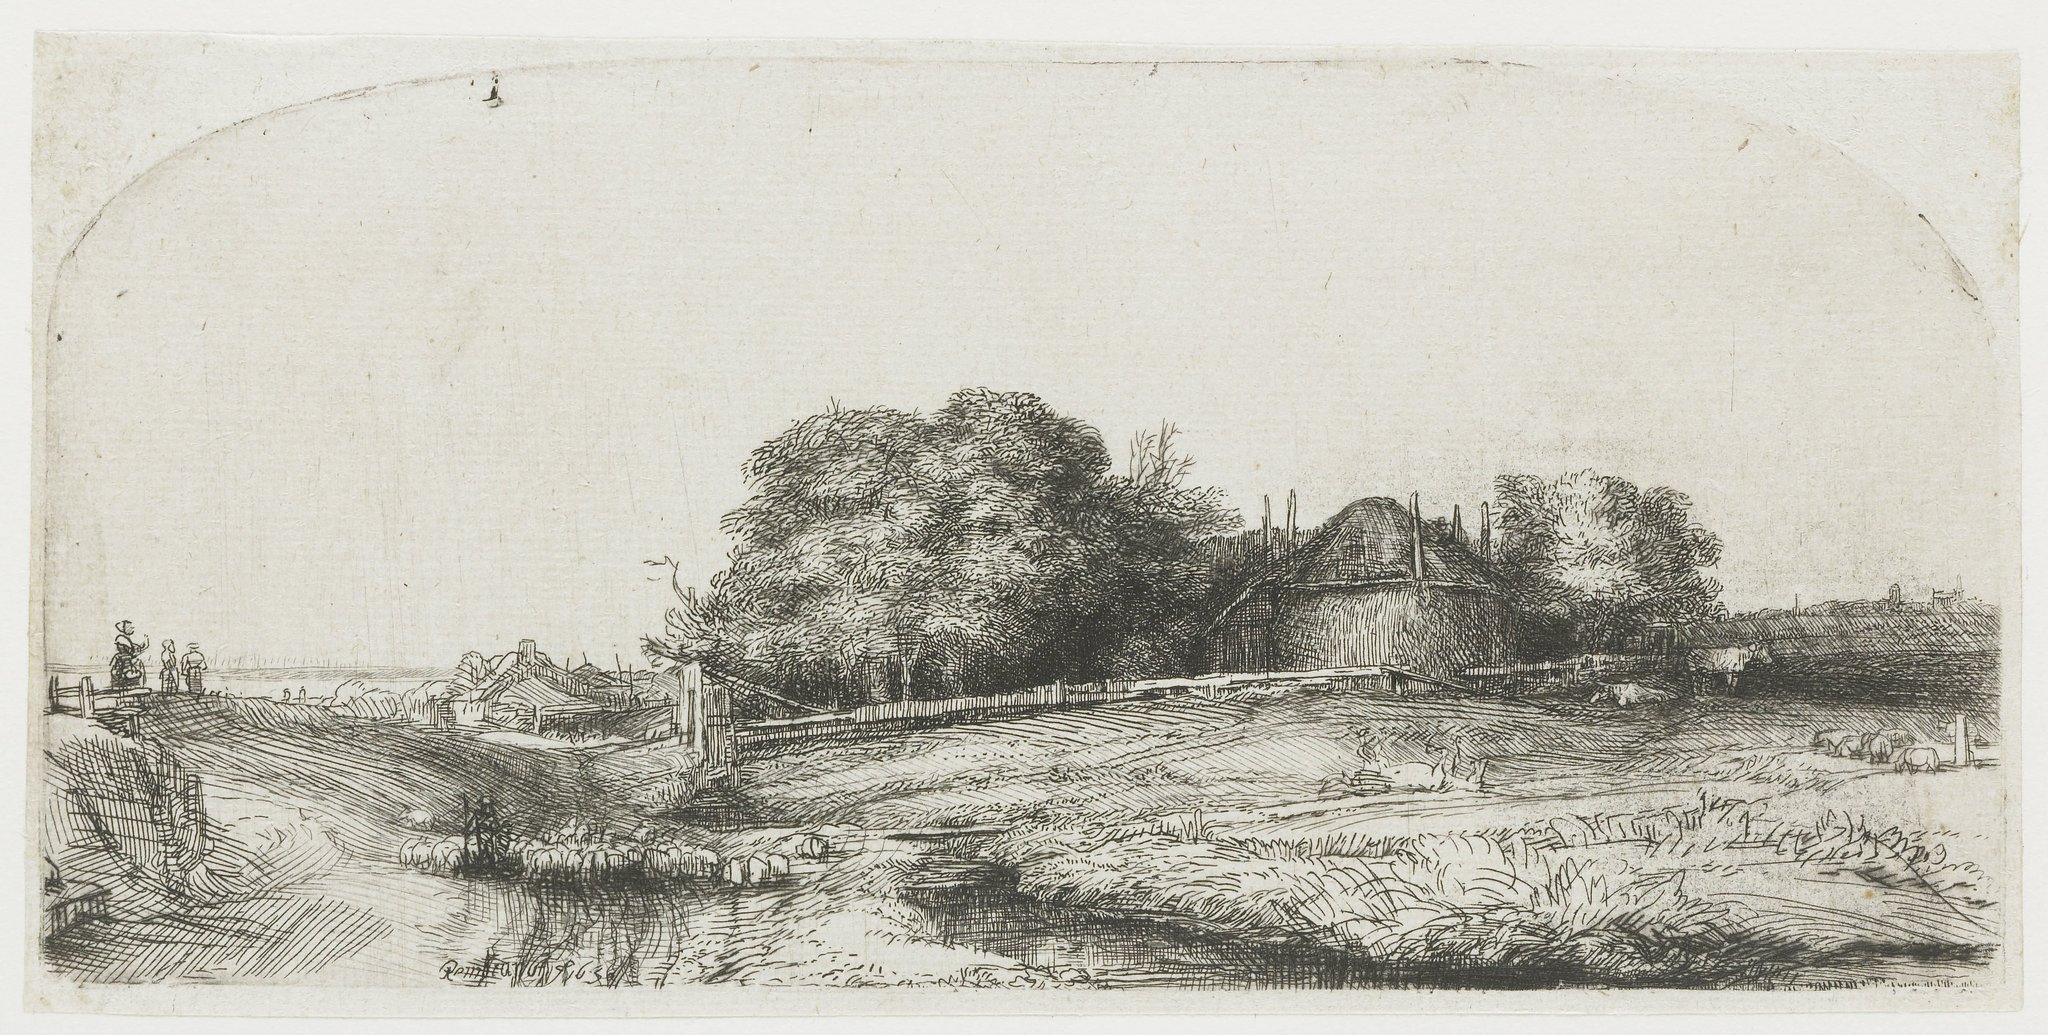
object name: print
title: Cottages and a hay barn on the Diemerdijk with a flock of sheep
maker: rembrandt van rijn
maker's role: draughtsman, painter, print maker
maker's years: 1606-1669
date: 1650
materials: paper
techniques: drypoint, etching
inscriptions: signature and date: ‘Rembrandt f 1652’, collector's mark: Lugt 240